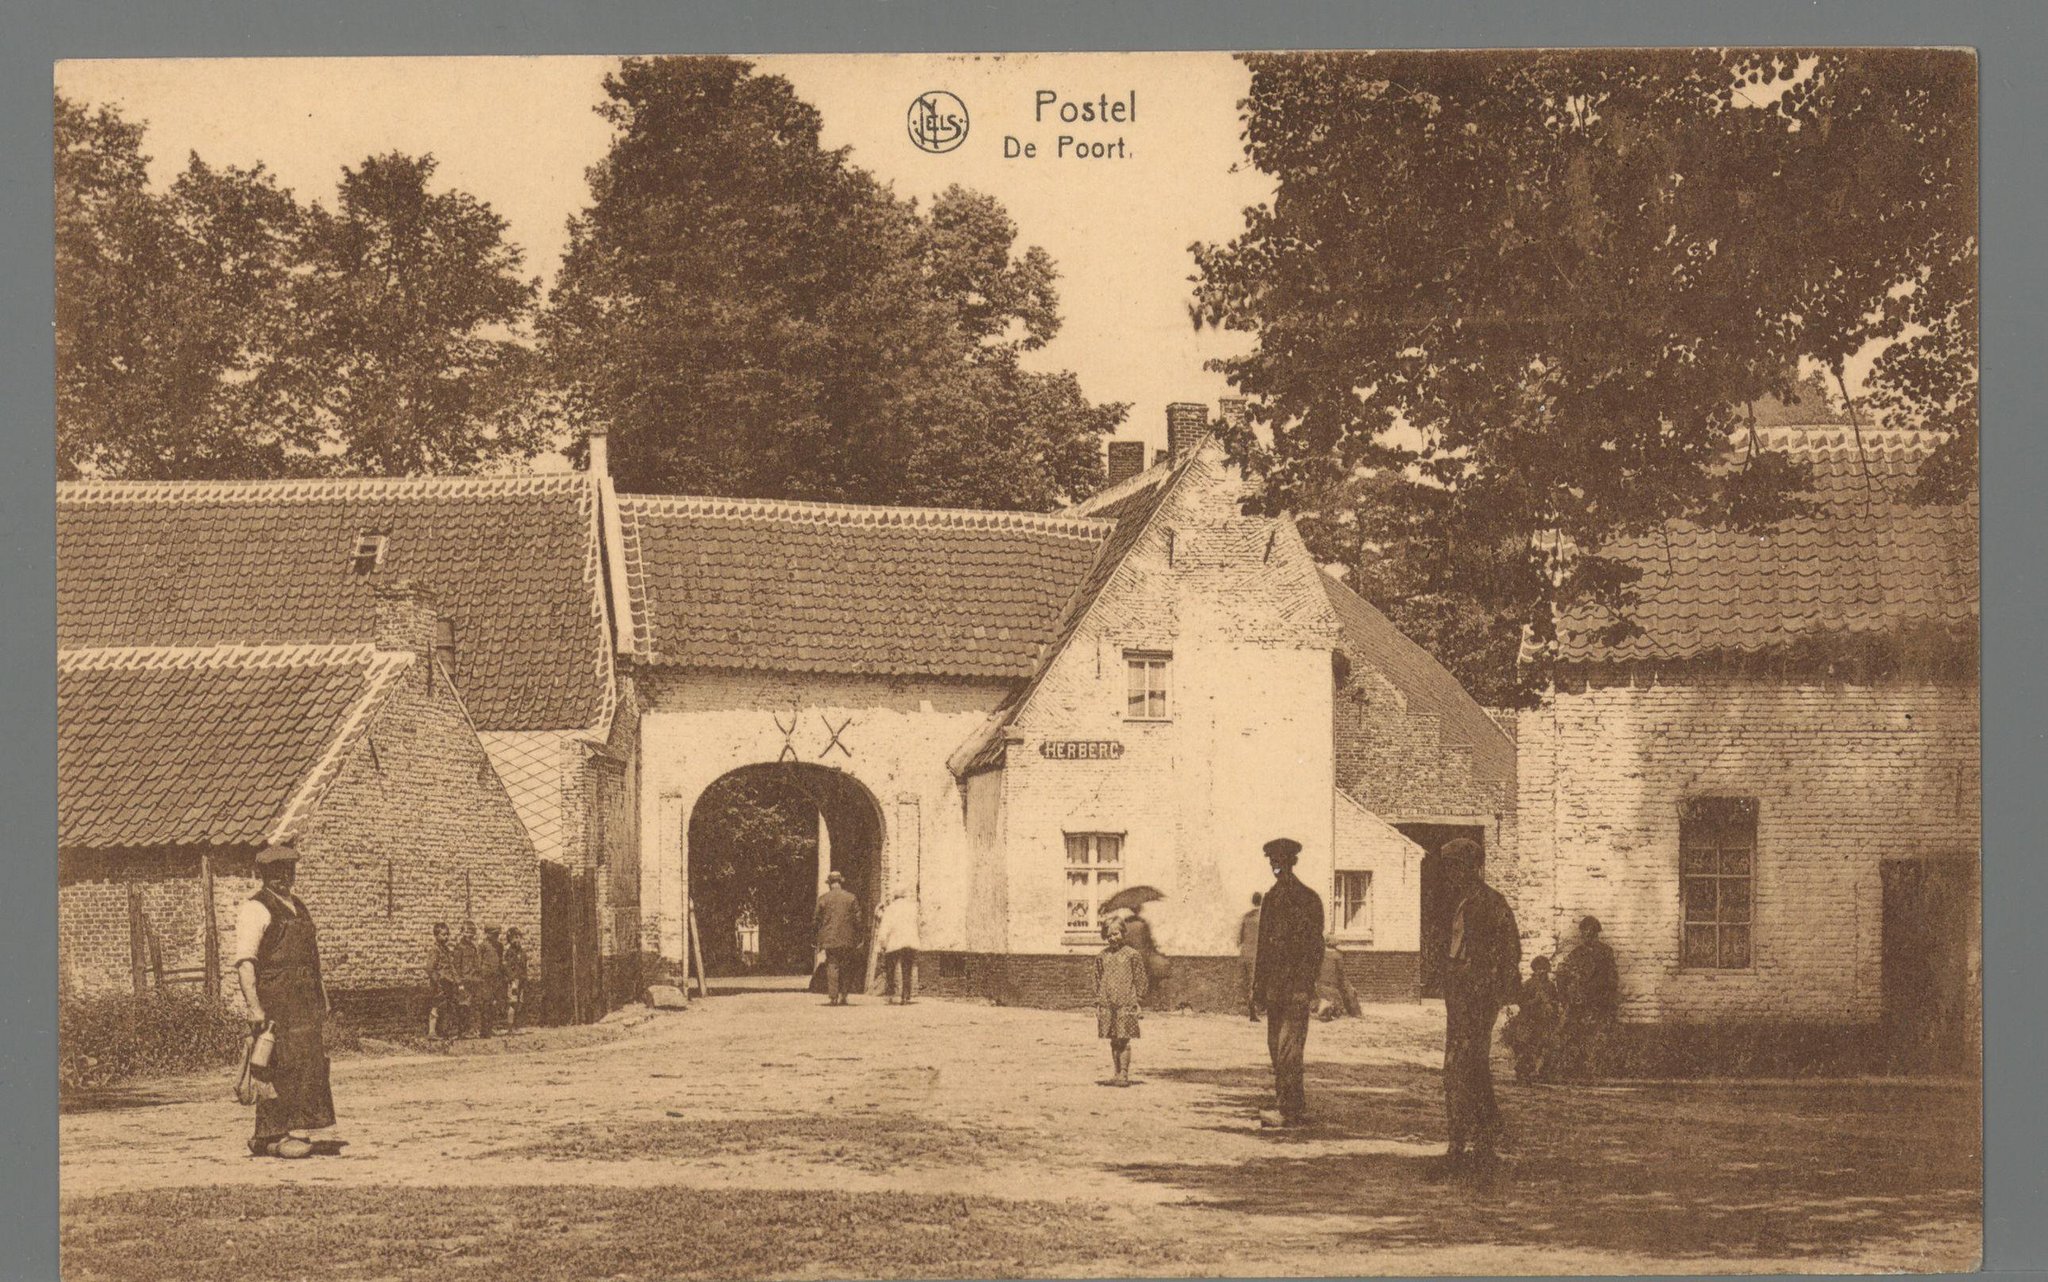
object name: ansichtkaart, prentbriefkaart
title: Postel. De Poort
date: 1907-1913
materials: cardboard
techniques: photograph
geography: brussels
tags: gate, entrance, village (+ city(-scape) with figures, staffage), hotel, hostelry, inn